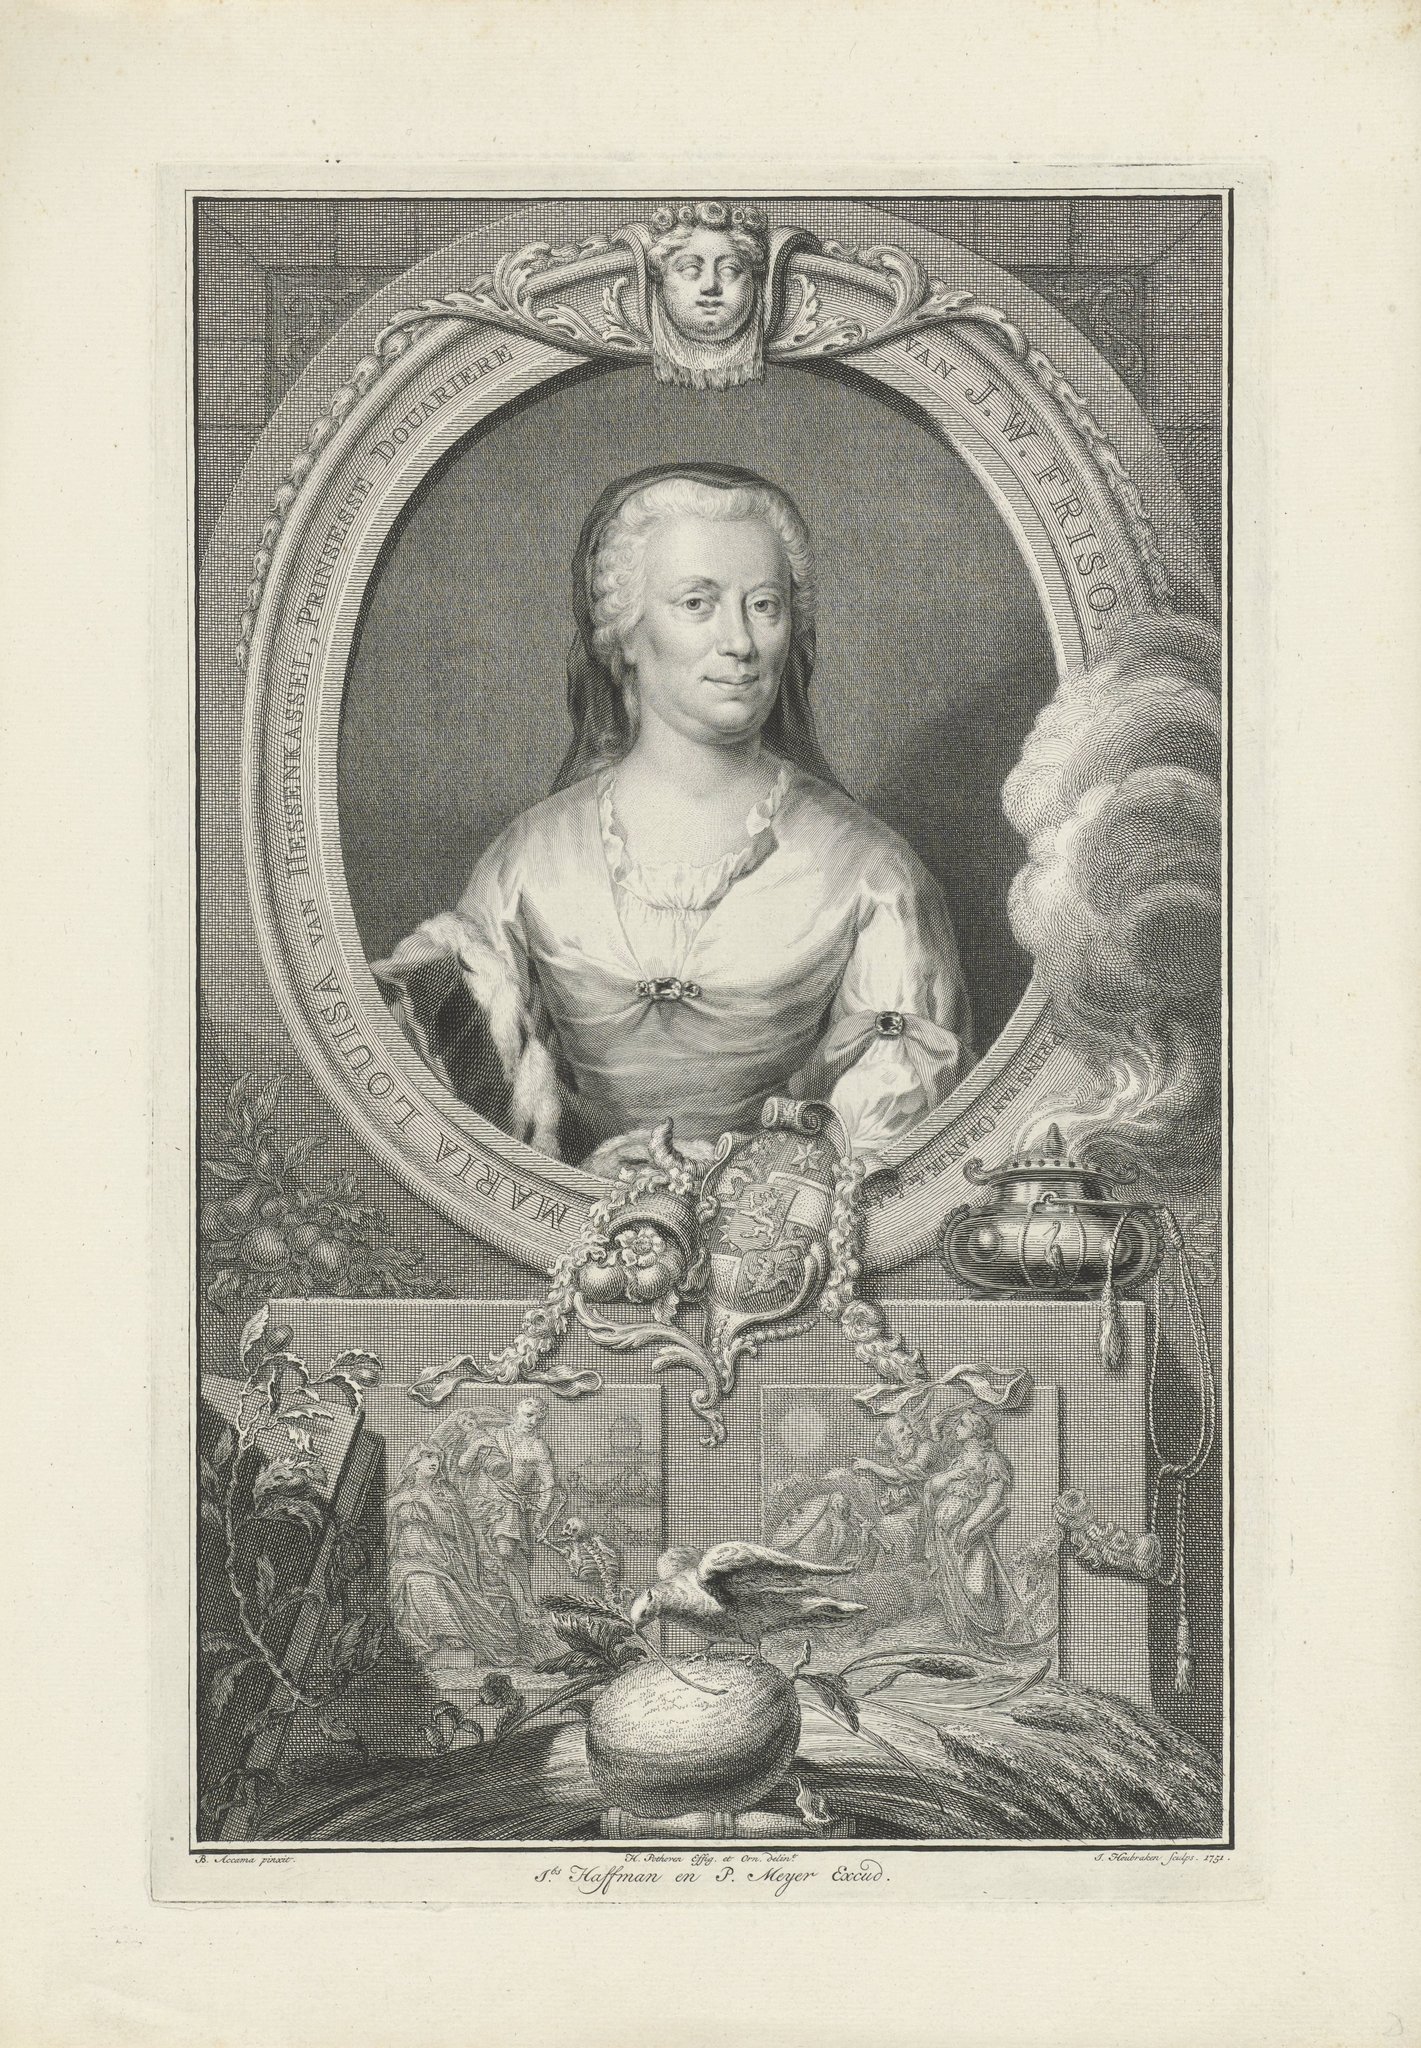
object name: print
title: Portret van Maria Louise, prinses van Oranje-Nassau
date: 1751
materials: paper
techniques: engraving, etching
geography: amsterdam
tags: kassel, leeuwarden, maria louisa van hessen-kassel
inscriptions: collector's mark: Lugt 2228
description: Portret van Maria Louise, prinses van Oranje-Nassau in een ovaal op een sokkel, waarop een bas-reliëf met twee allegorische voorstellingen, omringd met symbolen van eendracht en vrede zoals het koren en de duif.